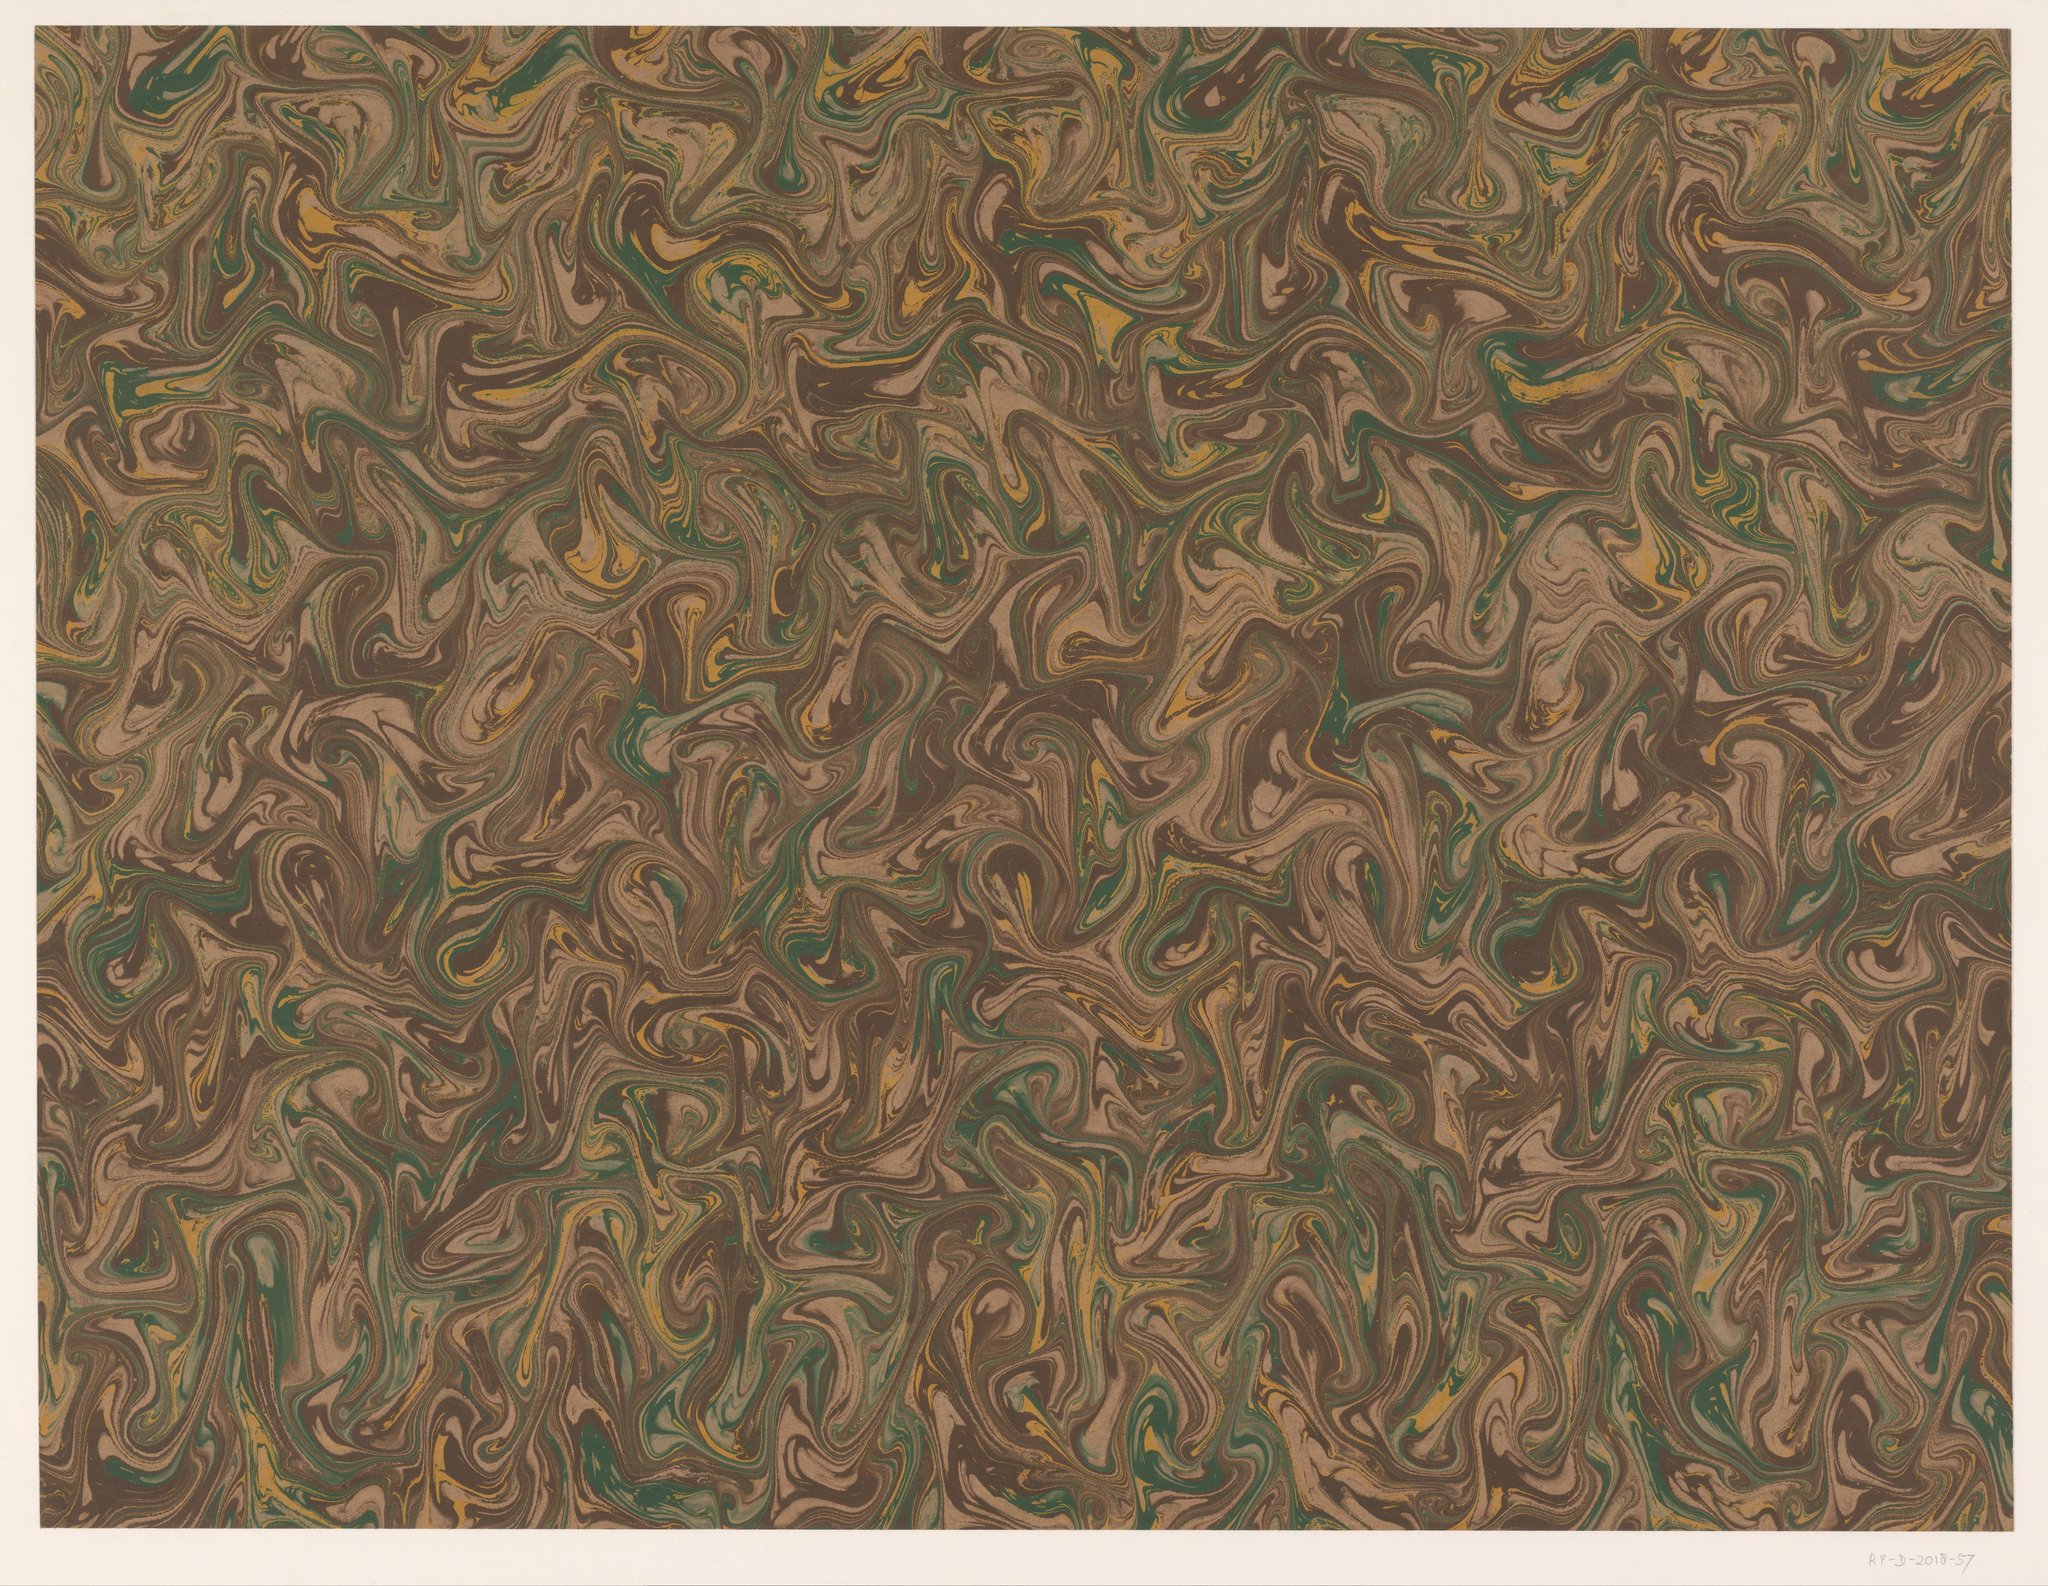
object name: marbled paper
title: Fantasiemarmer in bruin, groen en geel op bruin papier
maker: Anonymous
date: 1900-2000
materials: paint, paper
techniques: marbled paper